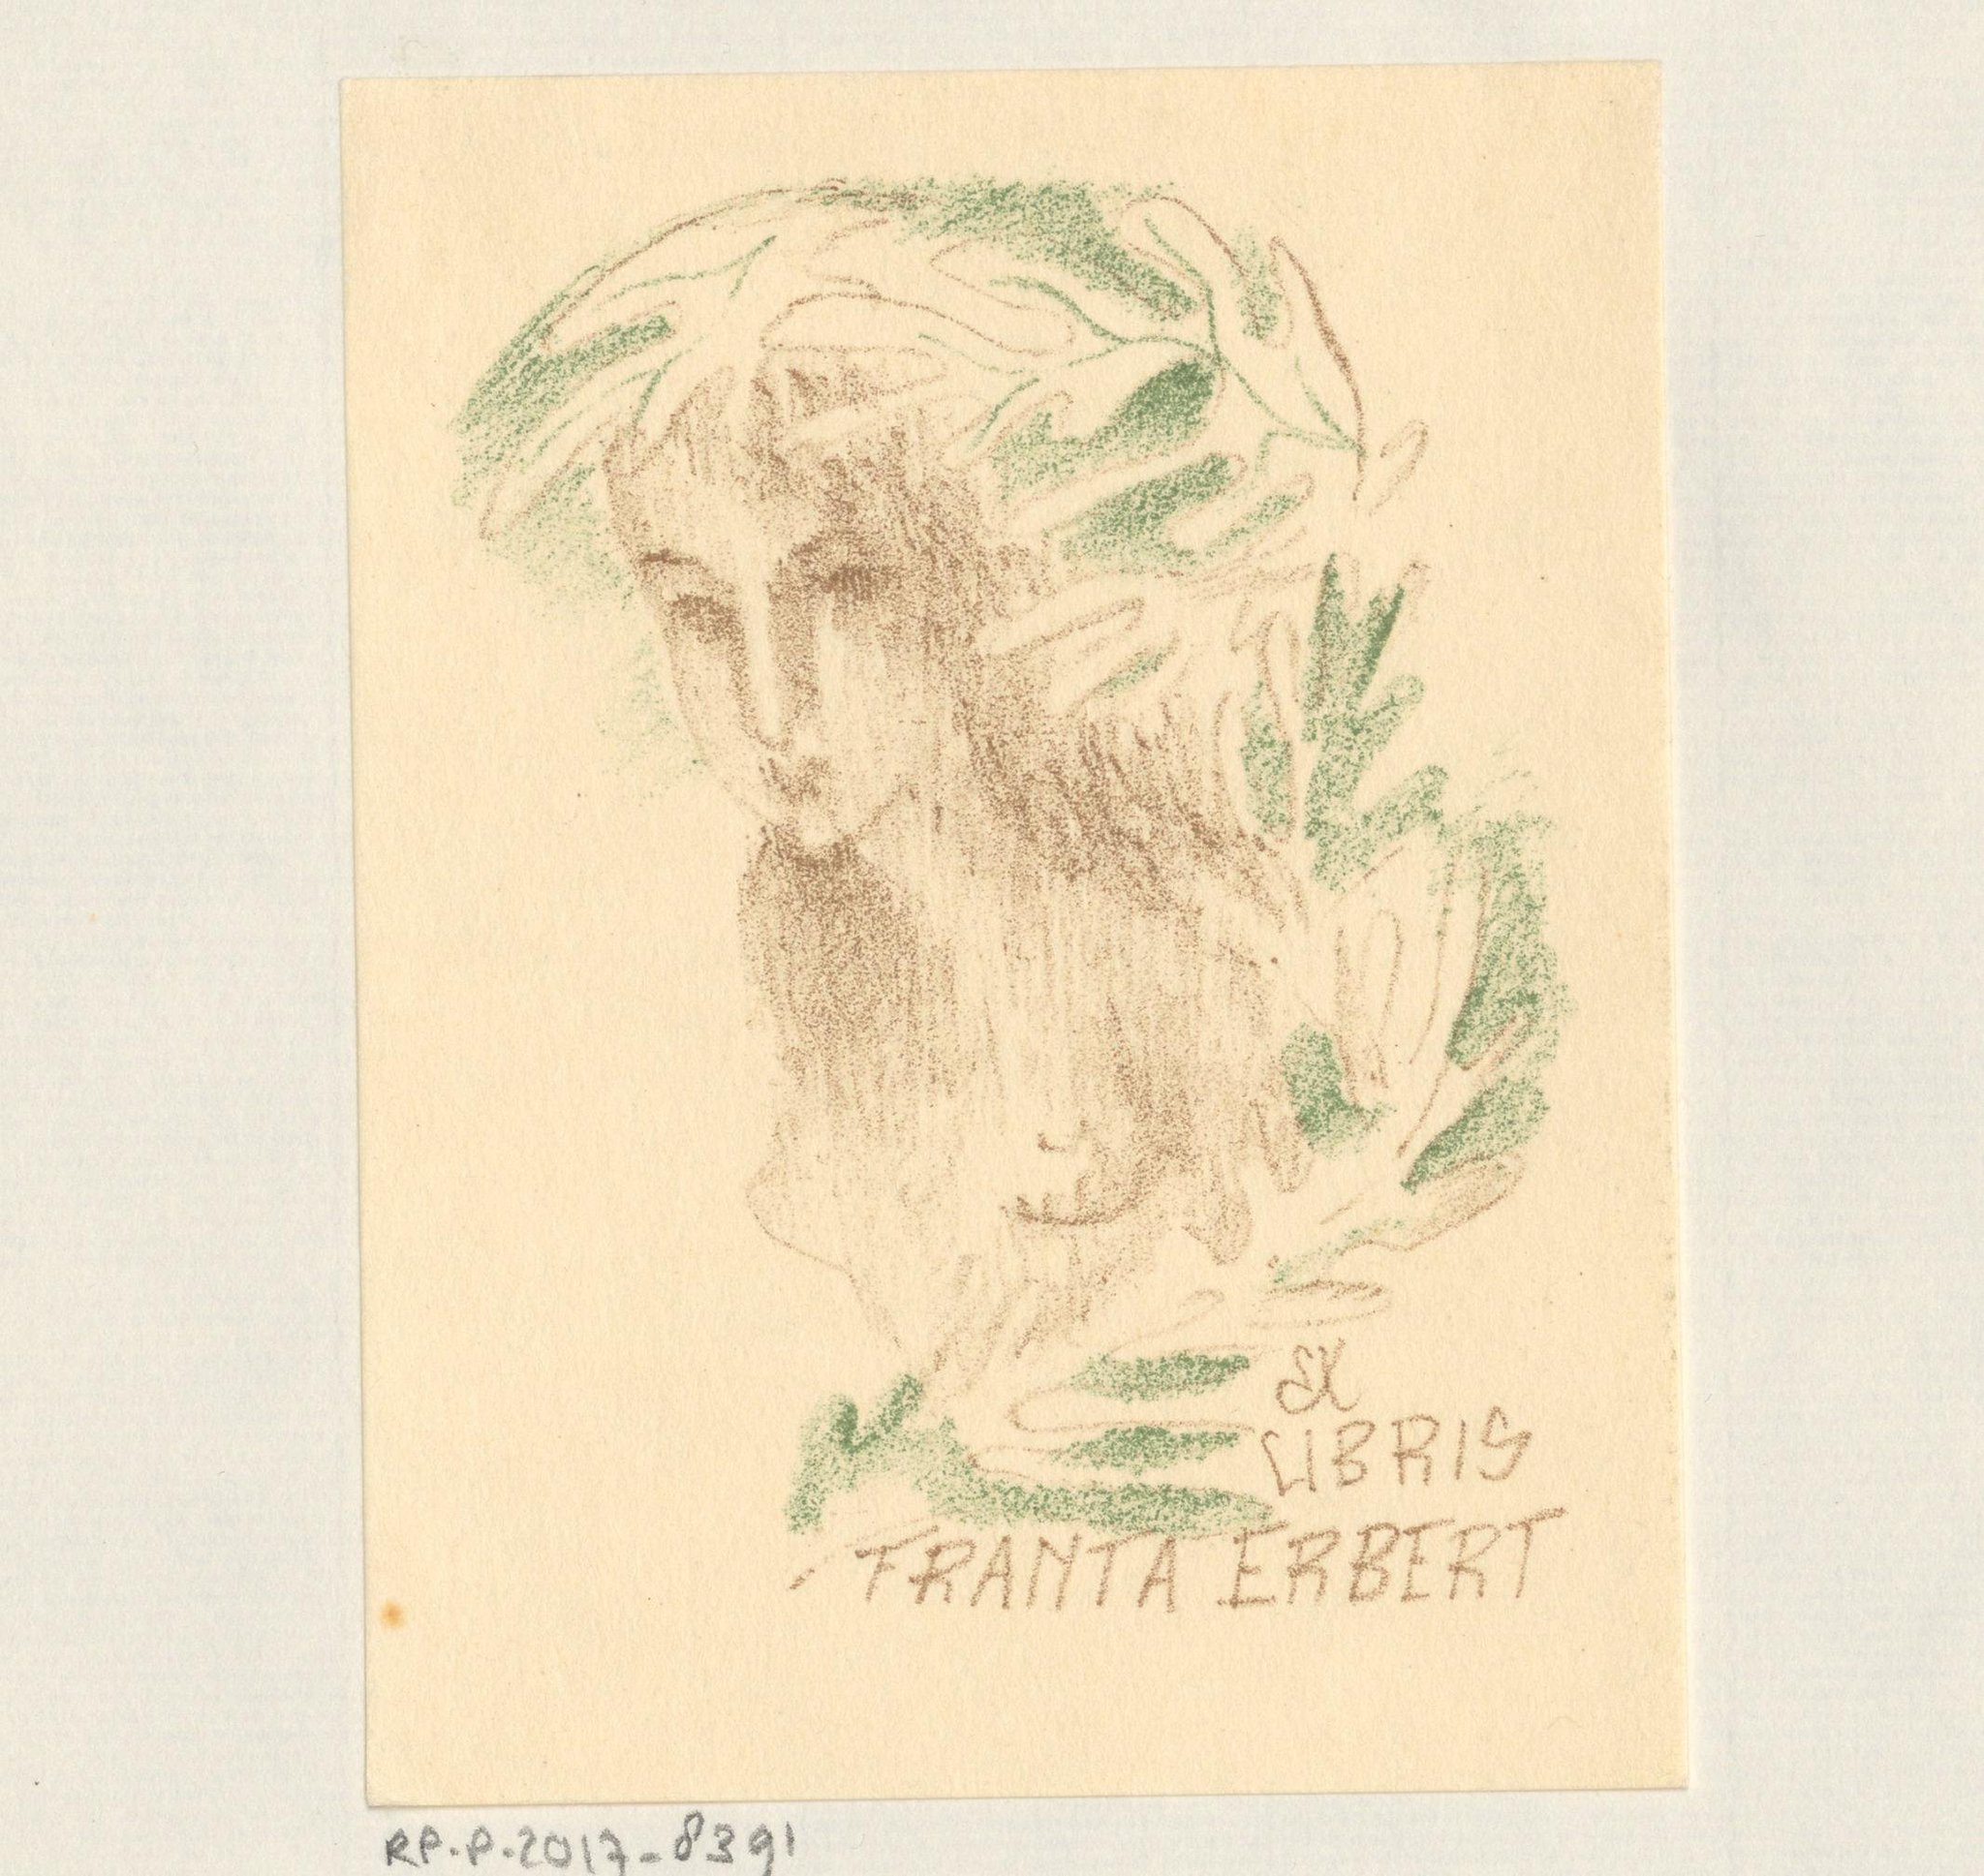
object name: bookplate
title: Ex libris van Franta Erbert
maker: Anonymous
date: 1900-1999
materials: paper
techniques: lithograph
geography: czech republic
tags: woman (showing herself) undressed, quasi-nude, plants and herbs